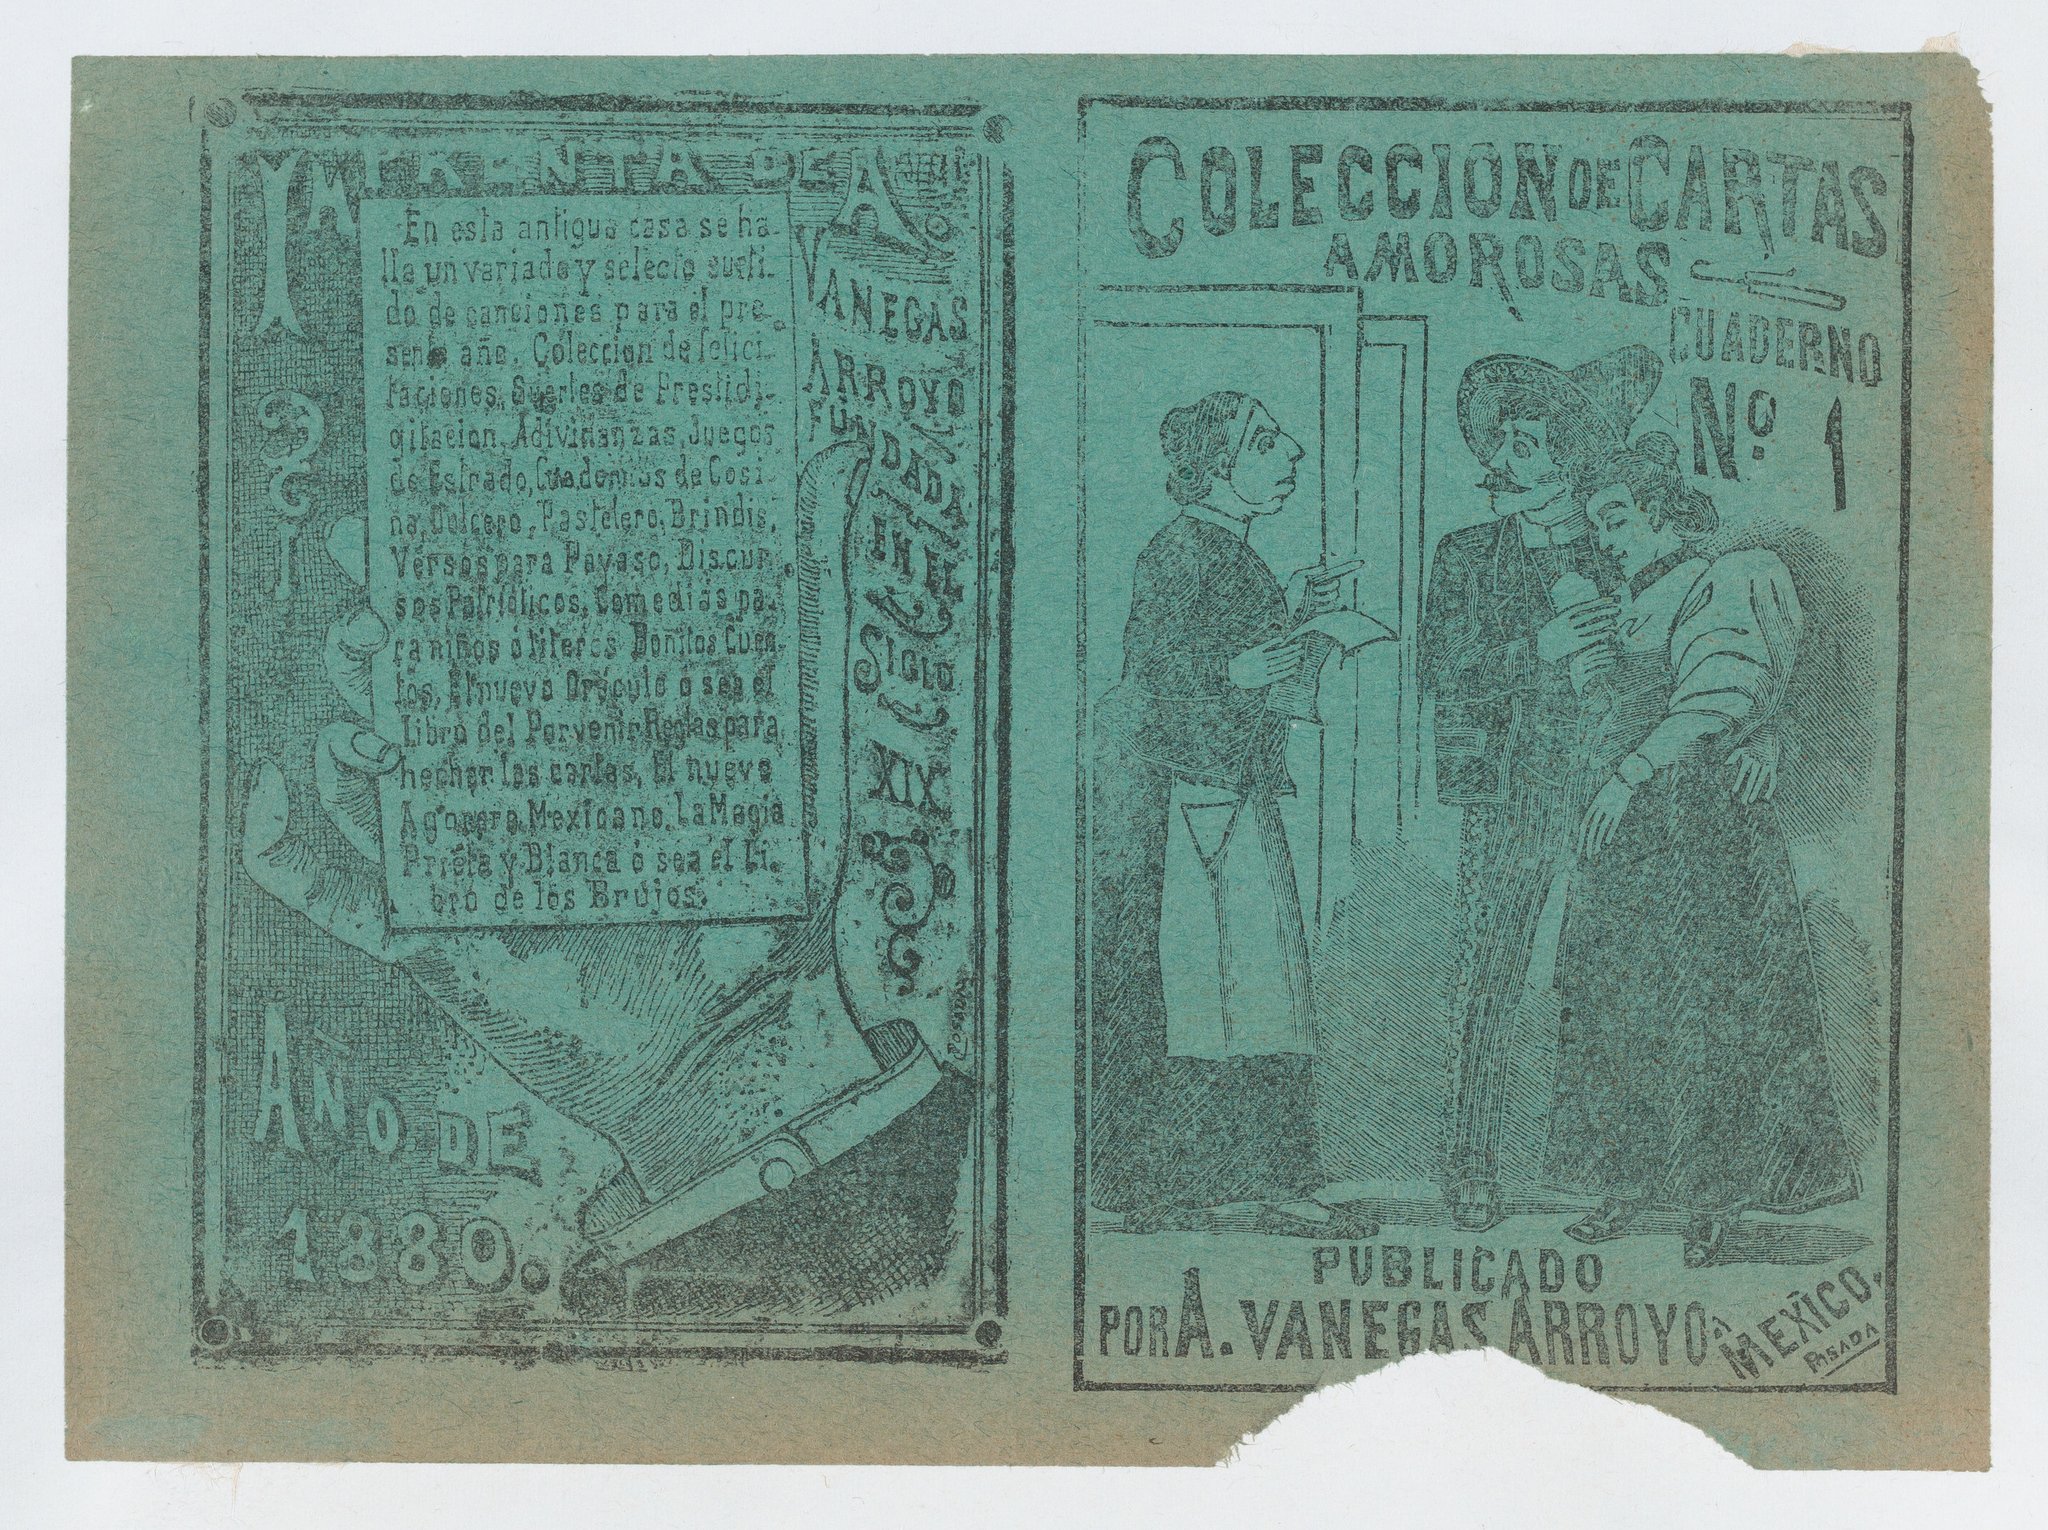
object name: print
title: Front and back covers printed on the same sheet for a collection of love letters (number 1)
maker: josé guadalupe posada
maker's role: artist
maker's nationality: mexican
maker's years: 1852-1913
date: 1900-1910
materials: metal, paper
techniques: engraving, letterpress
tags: men,women